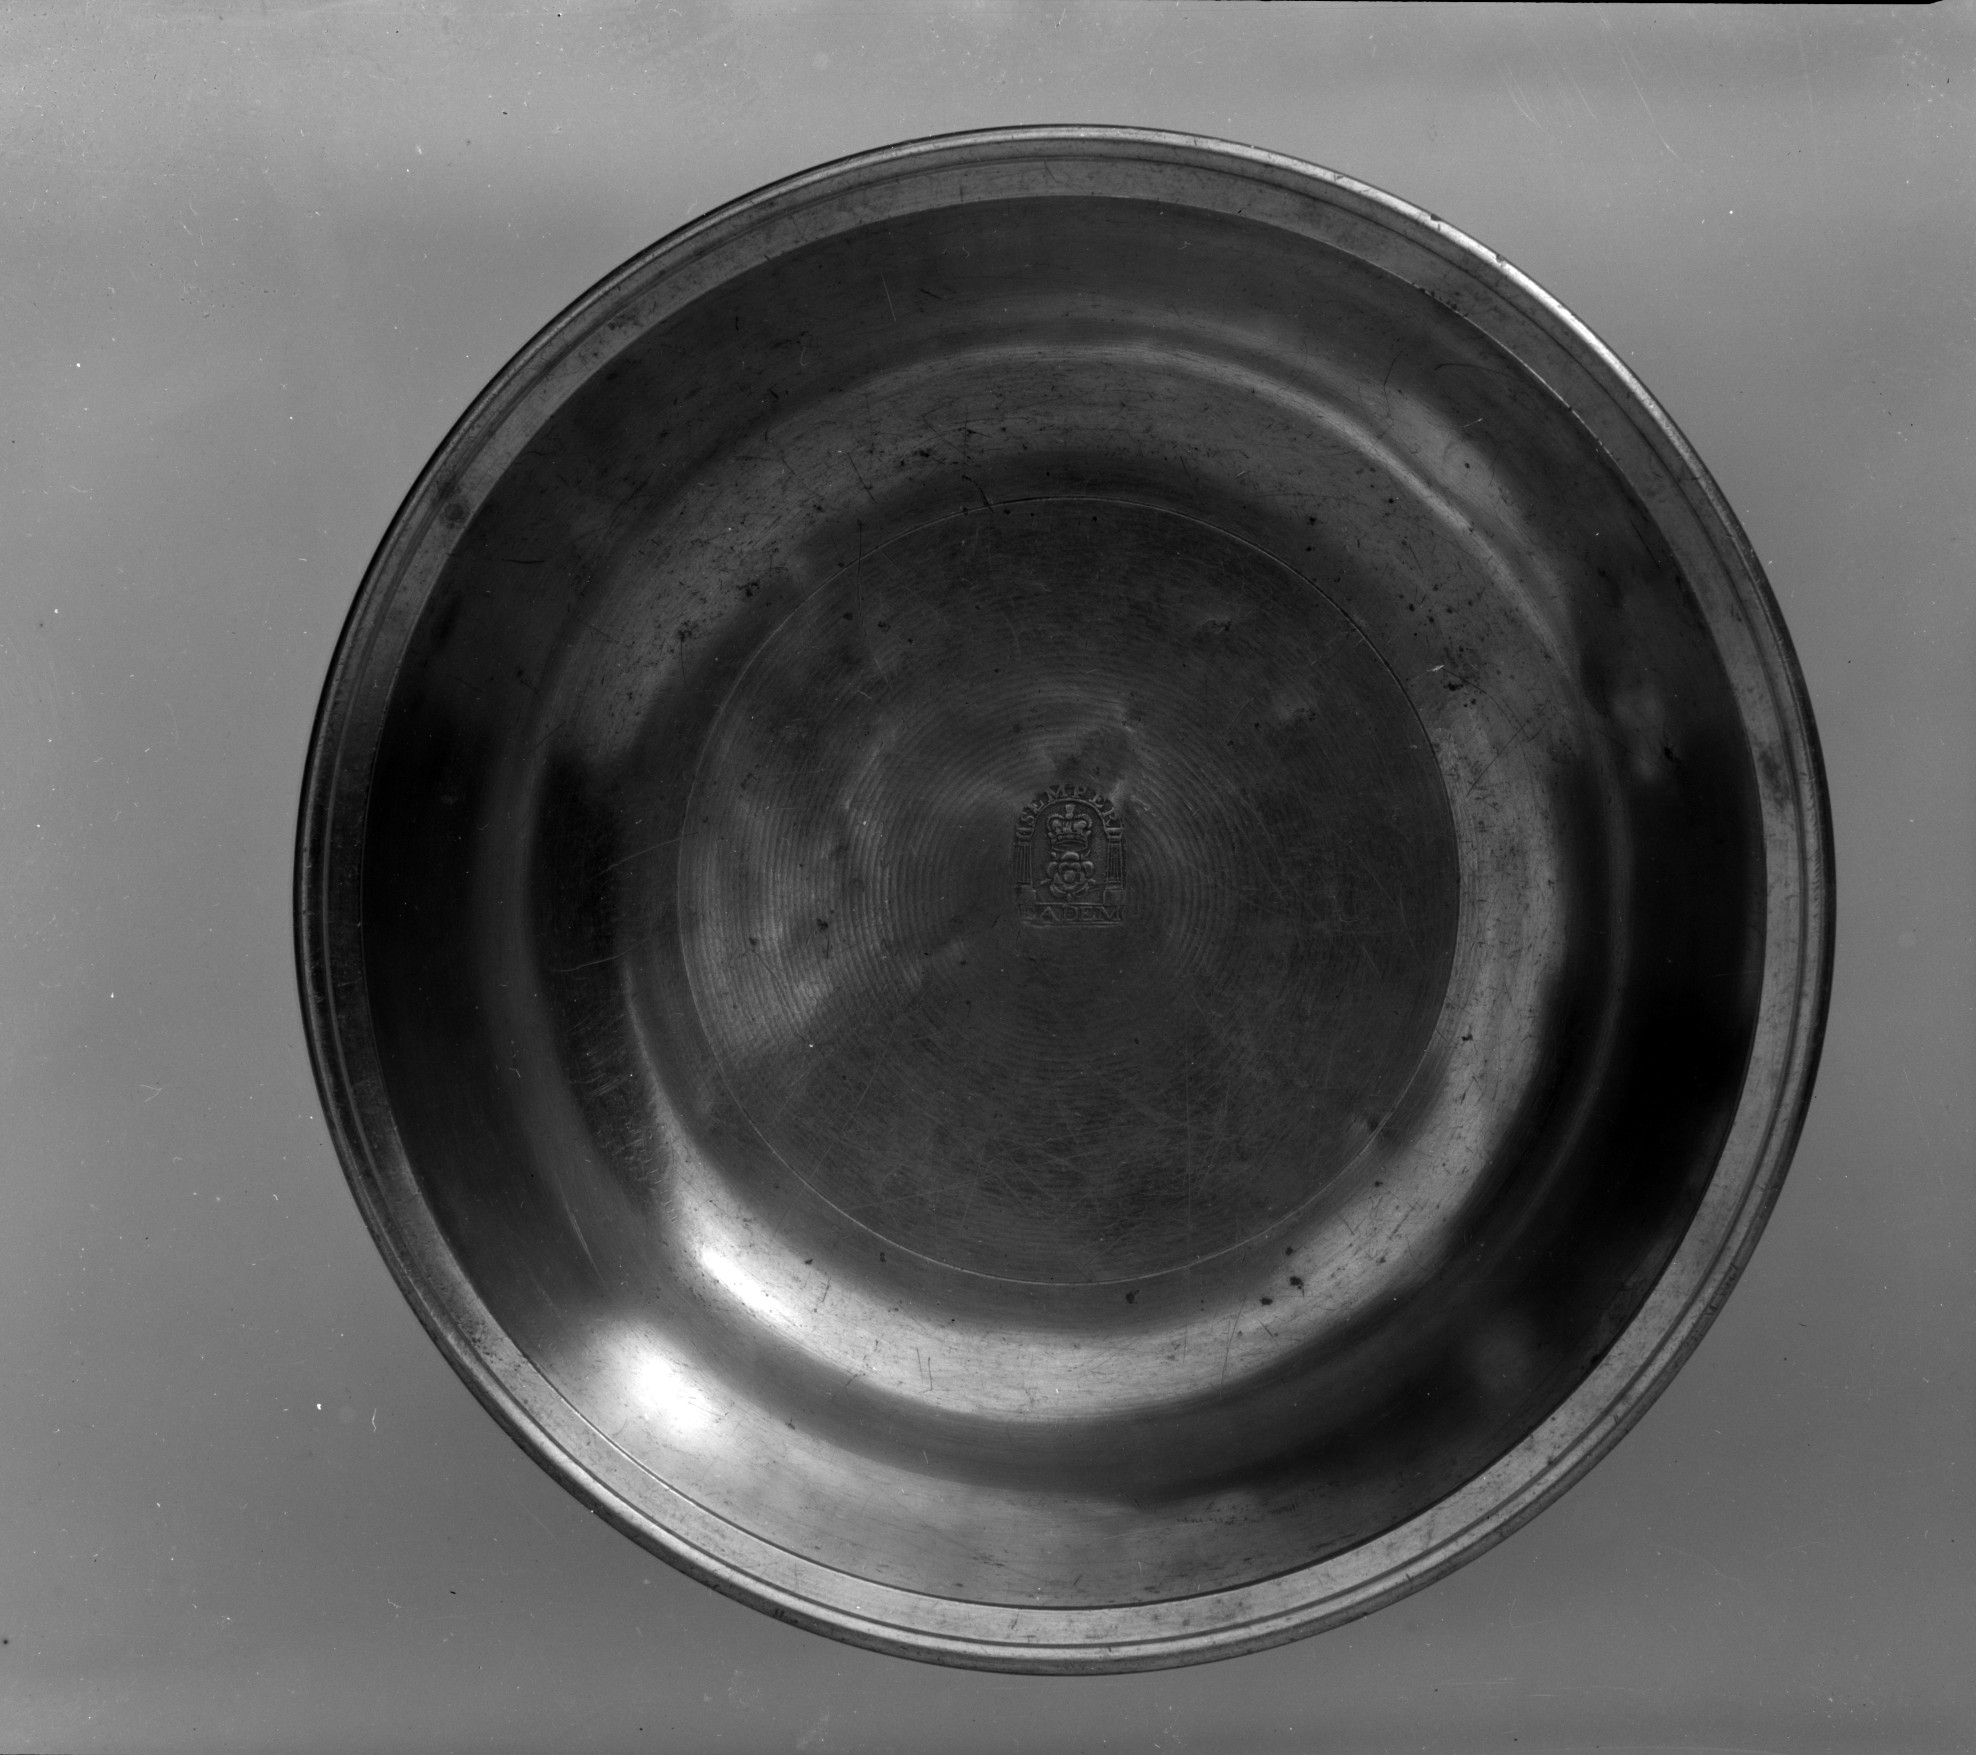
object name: basin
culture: american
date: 1760-1780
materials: pewter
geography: united states